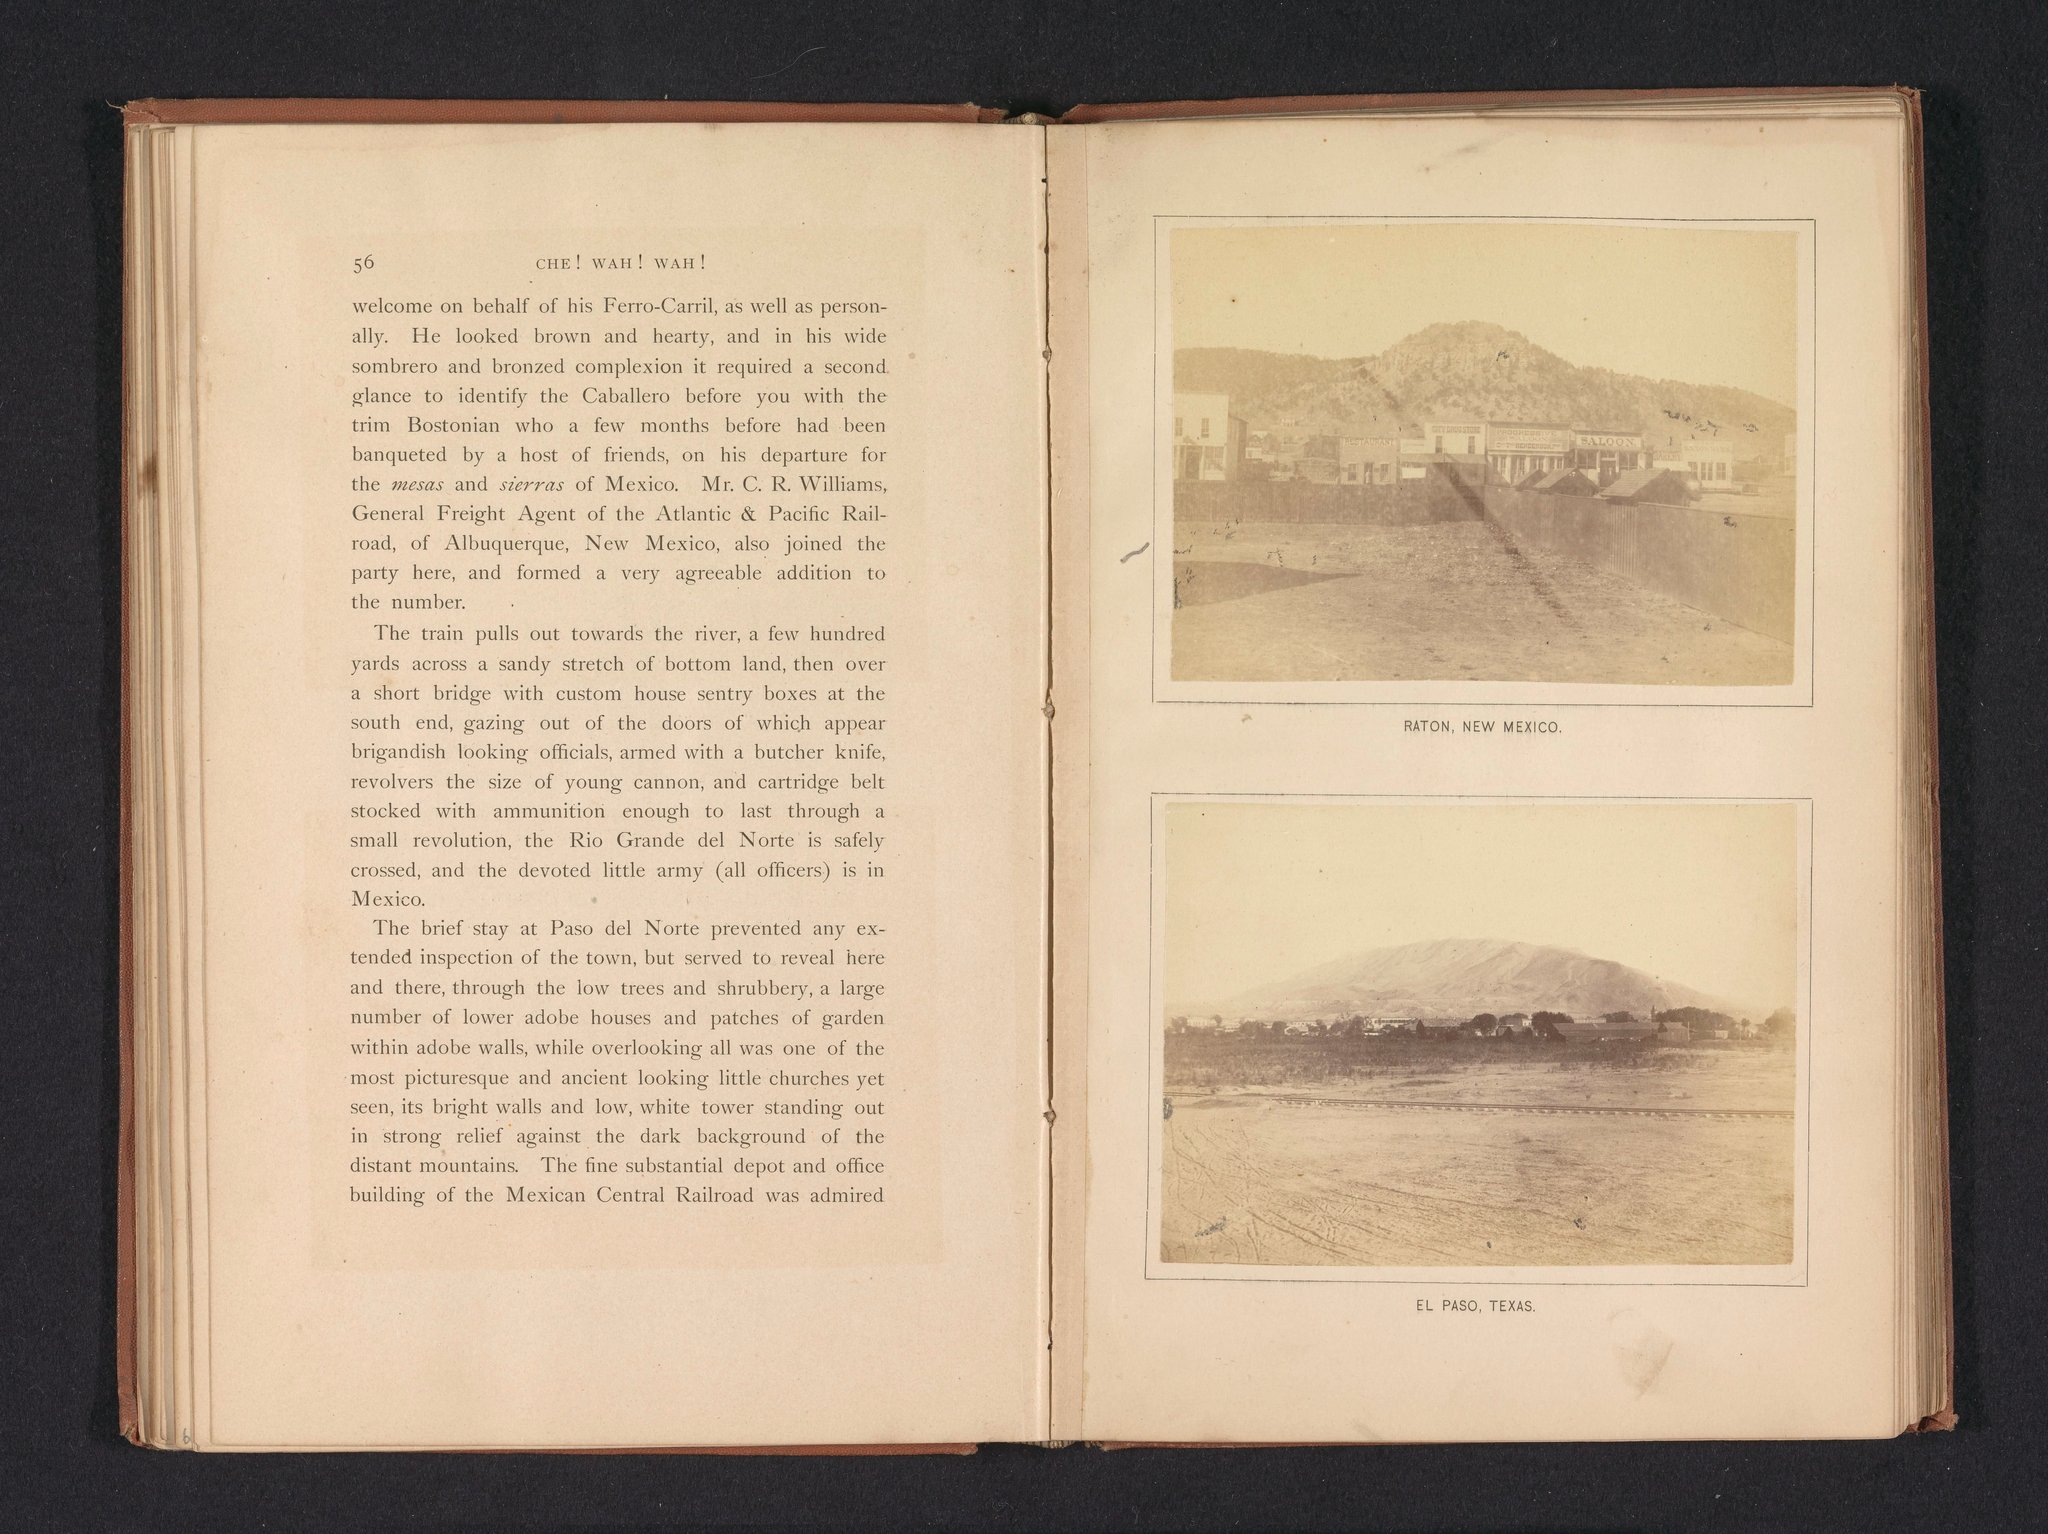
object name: page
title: Gezicht op Raton en El Paso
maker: r.d. cleveland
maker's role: fotograaf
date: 1873-1883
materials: photographic support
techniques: albumen print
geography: united states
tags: city-view, and landscape with man-made constructions, desert, united states of america